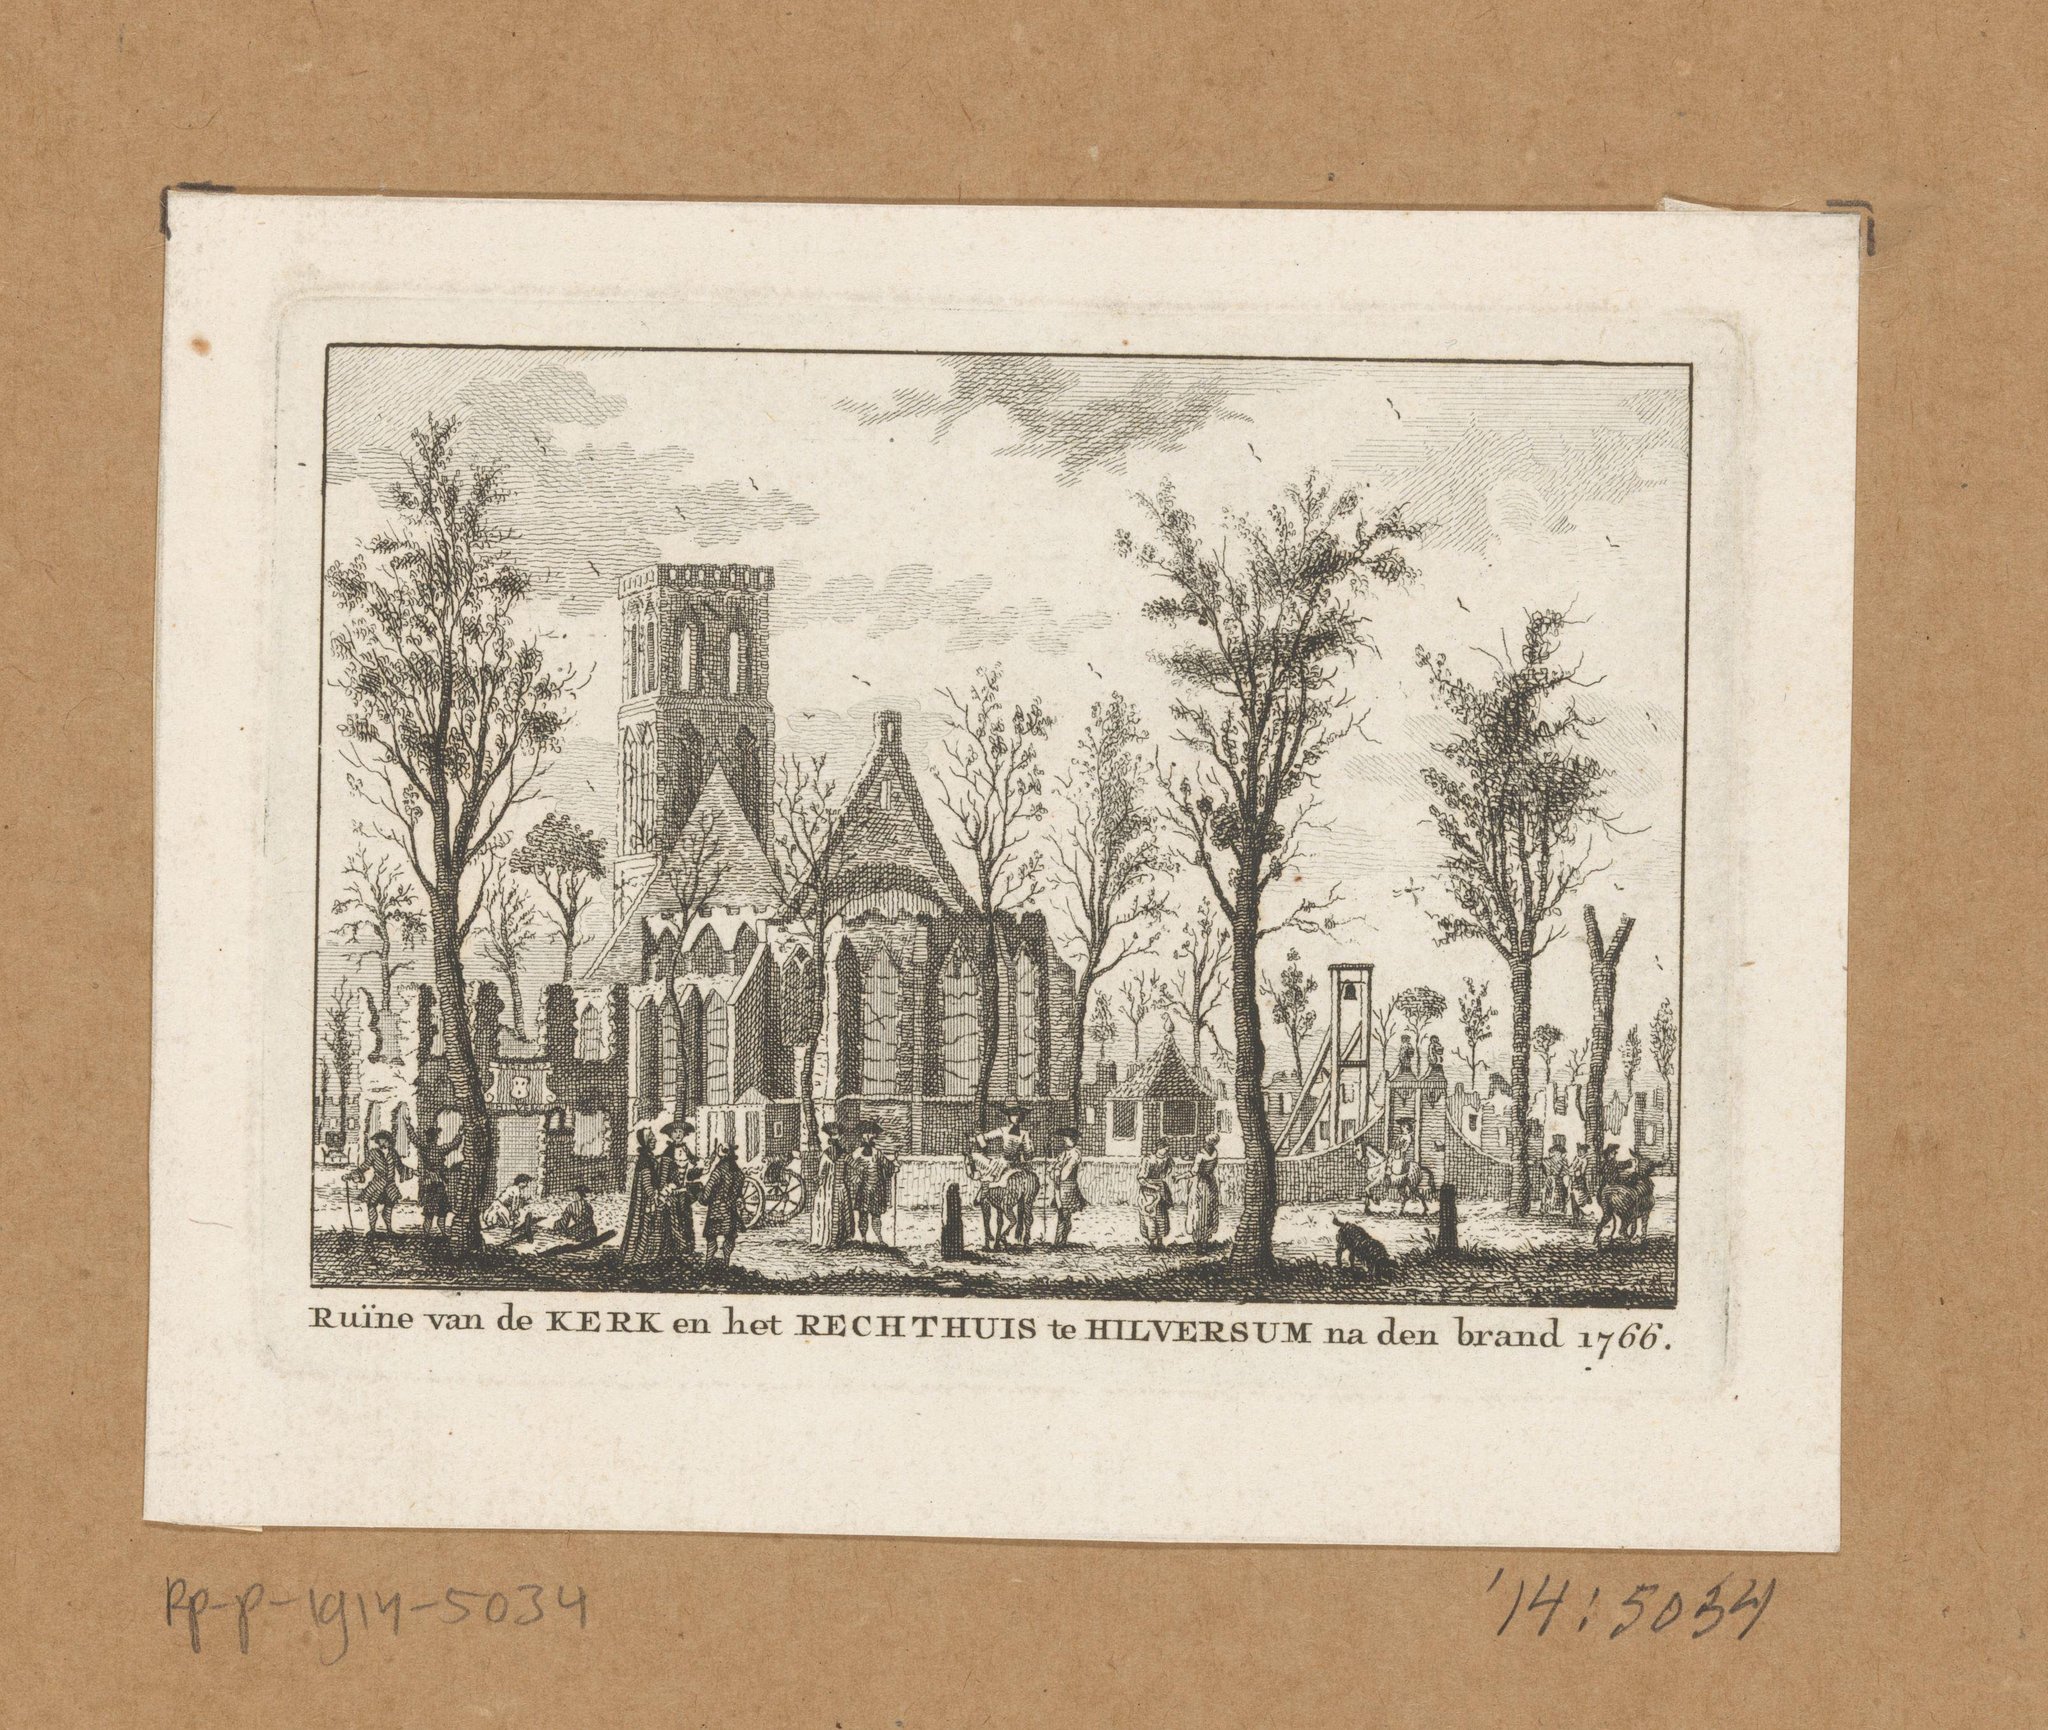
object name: print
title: Gezicht op de kerk en het rechthuis van Hilversum na de brand van 1766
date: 1770-1800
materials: paper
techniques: etching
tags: ruin of church, monastery, etc., village street (+ city(-scape) with figures, staffage)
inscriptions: collector's mark: Lugt 2228